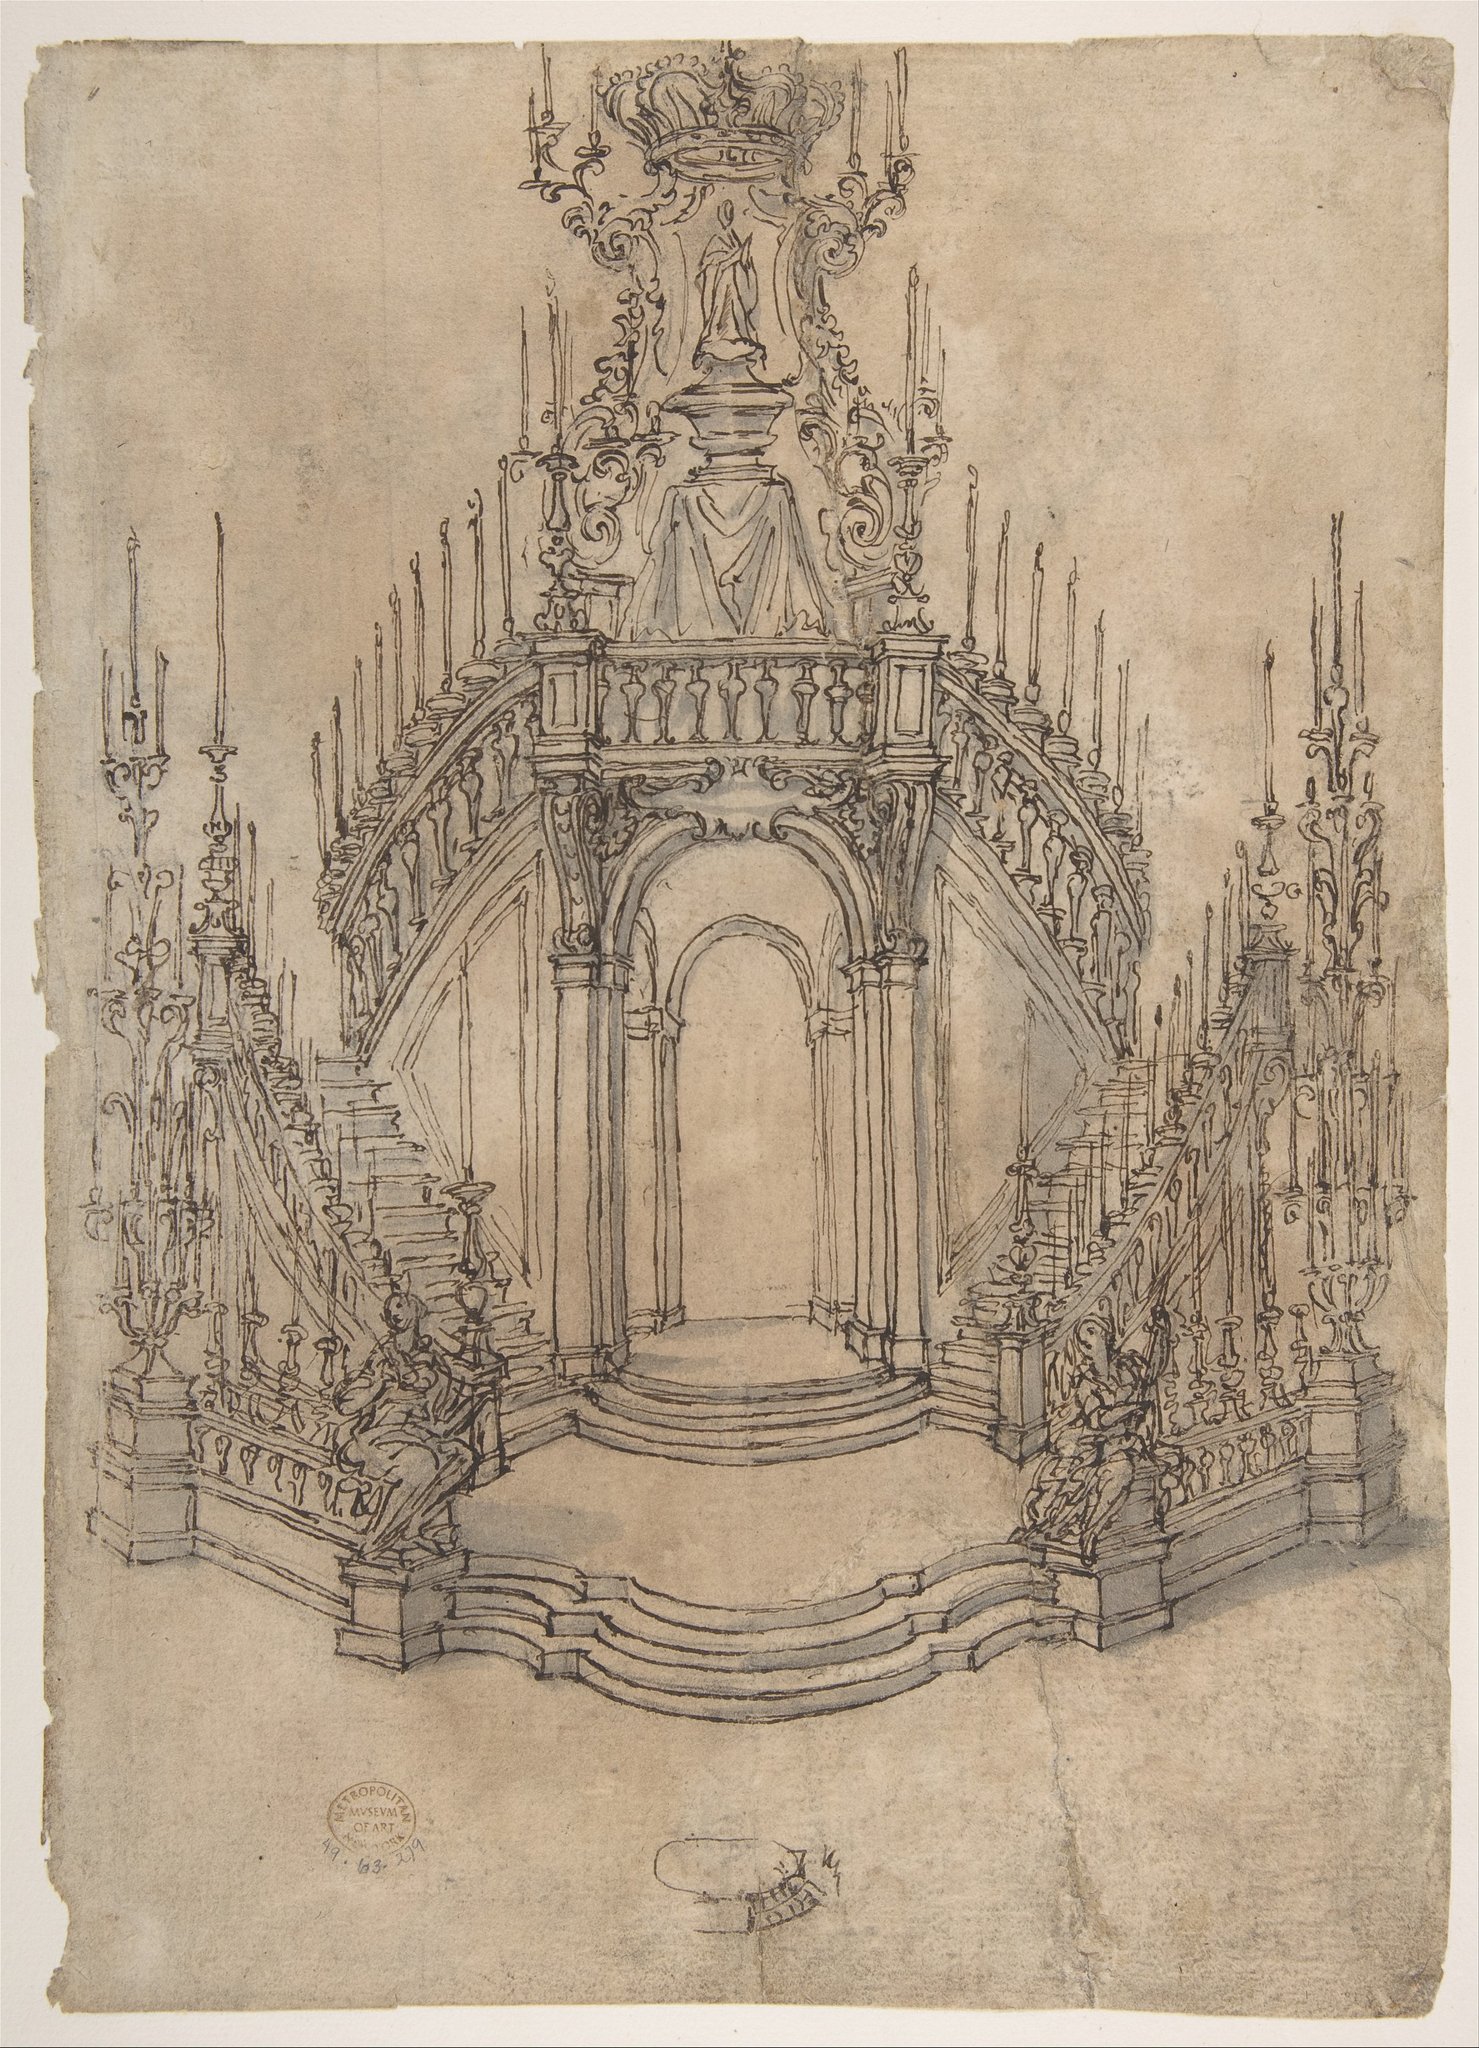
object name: drawing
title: Designs for a Funerary Monument with Stairs (recto); Various Funerary Monument Designs (verso)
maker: giovanni battista foggini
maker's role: artist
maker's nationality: italian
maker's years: 1652-1725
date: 1672-1725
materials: chalk, graphite, ink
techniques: brush, pen, wash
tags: architecture,monuments